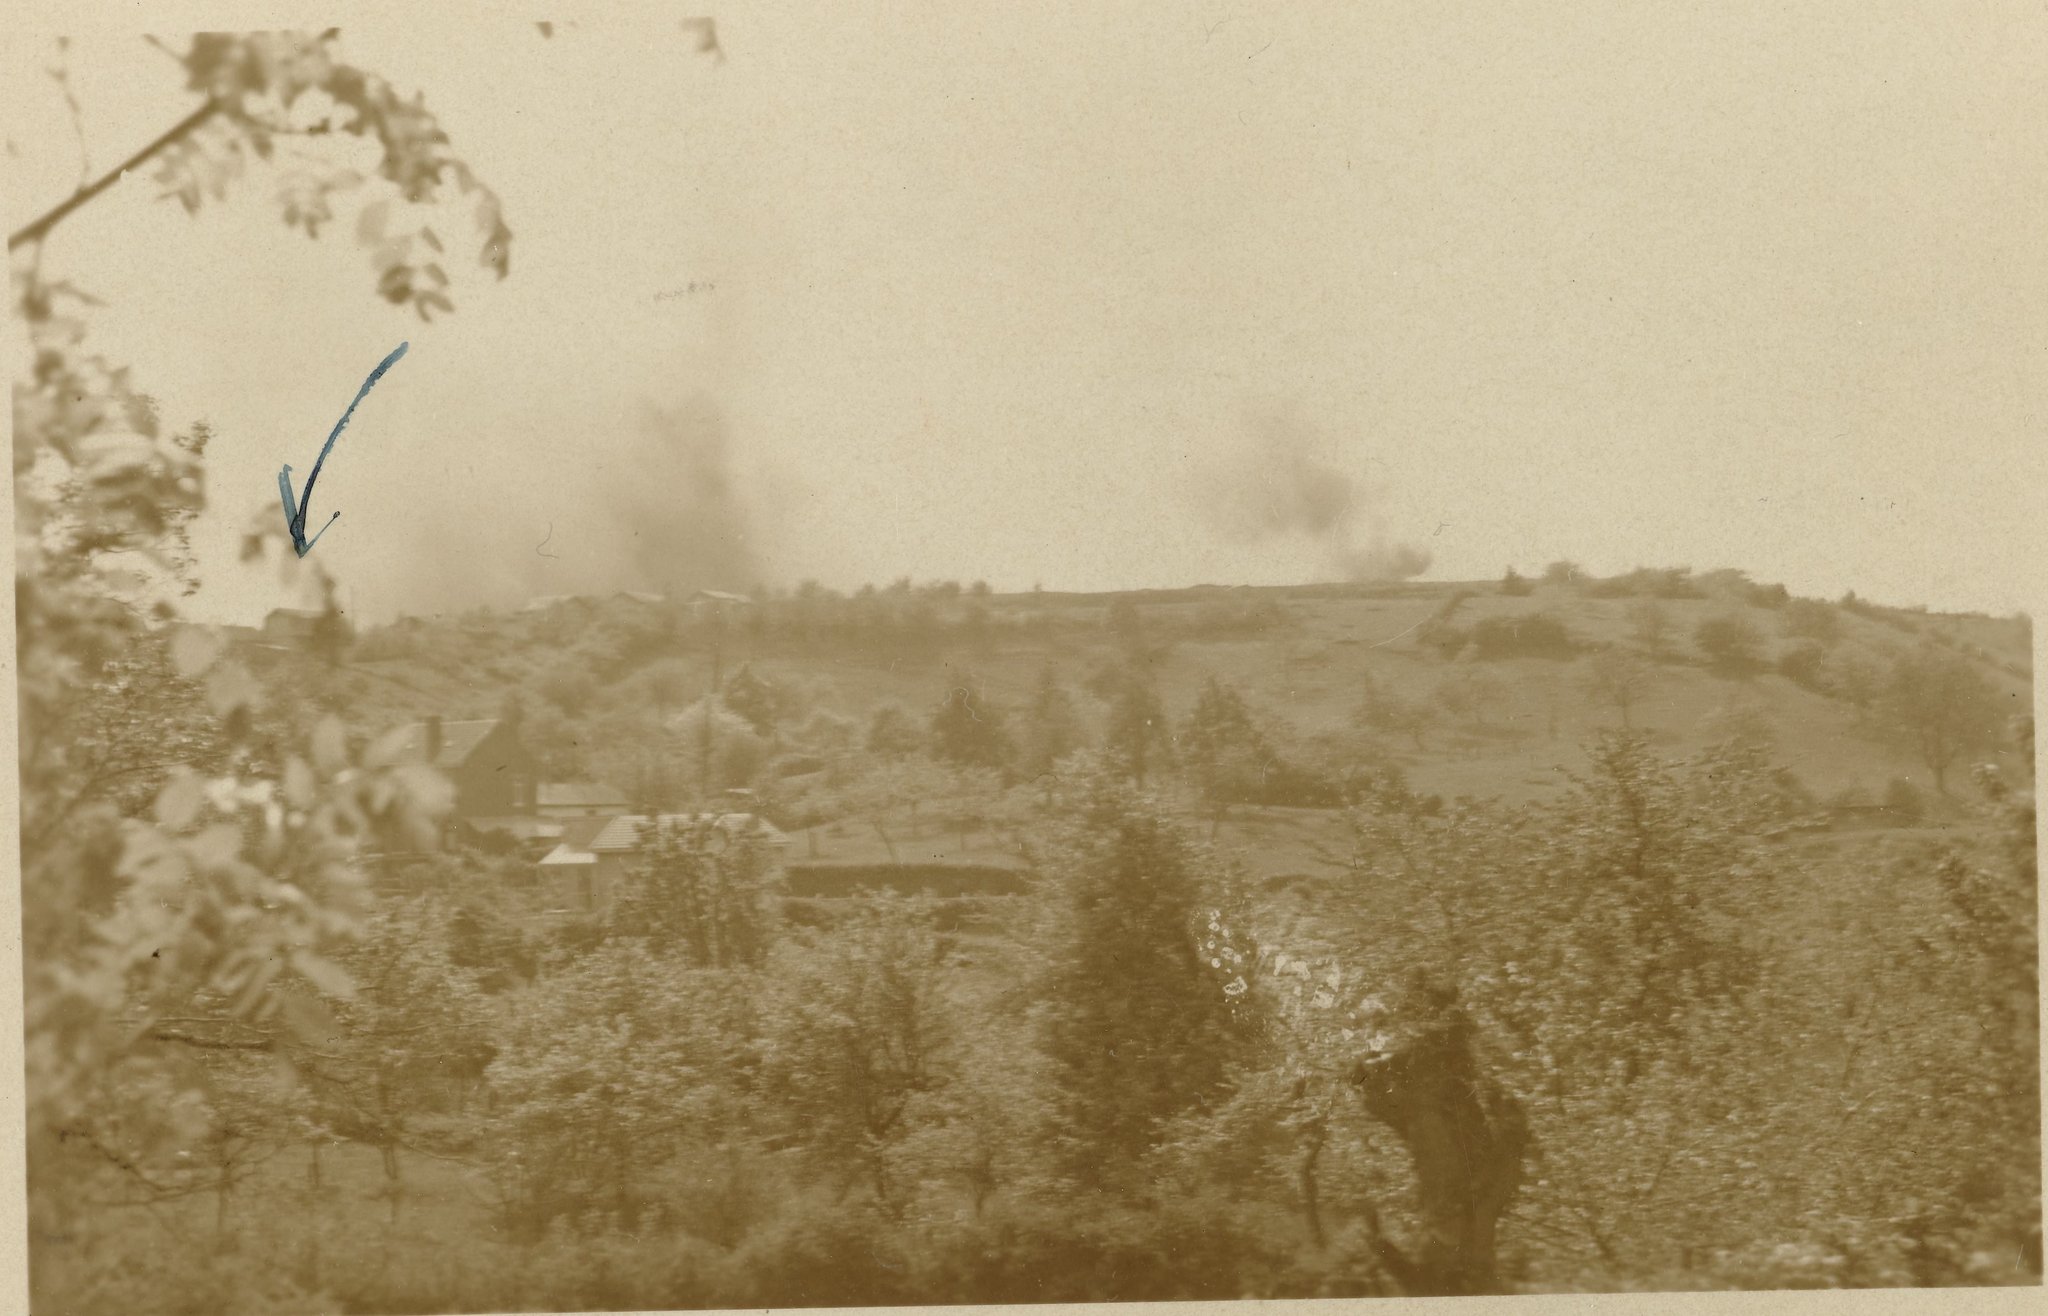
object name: photograph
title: Landschap met in de verte rookpluimen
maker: Anonymous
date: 1940-1945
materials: photographic support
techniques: gelatin silver print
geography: france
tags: netherlands, germany, france, belgium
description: Landschap met in de verte rookpluimen. Volgens het opschrift betreft het een aanval op een fort. Foto behorend bij album 'Kriegserinnerungen'.